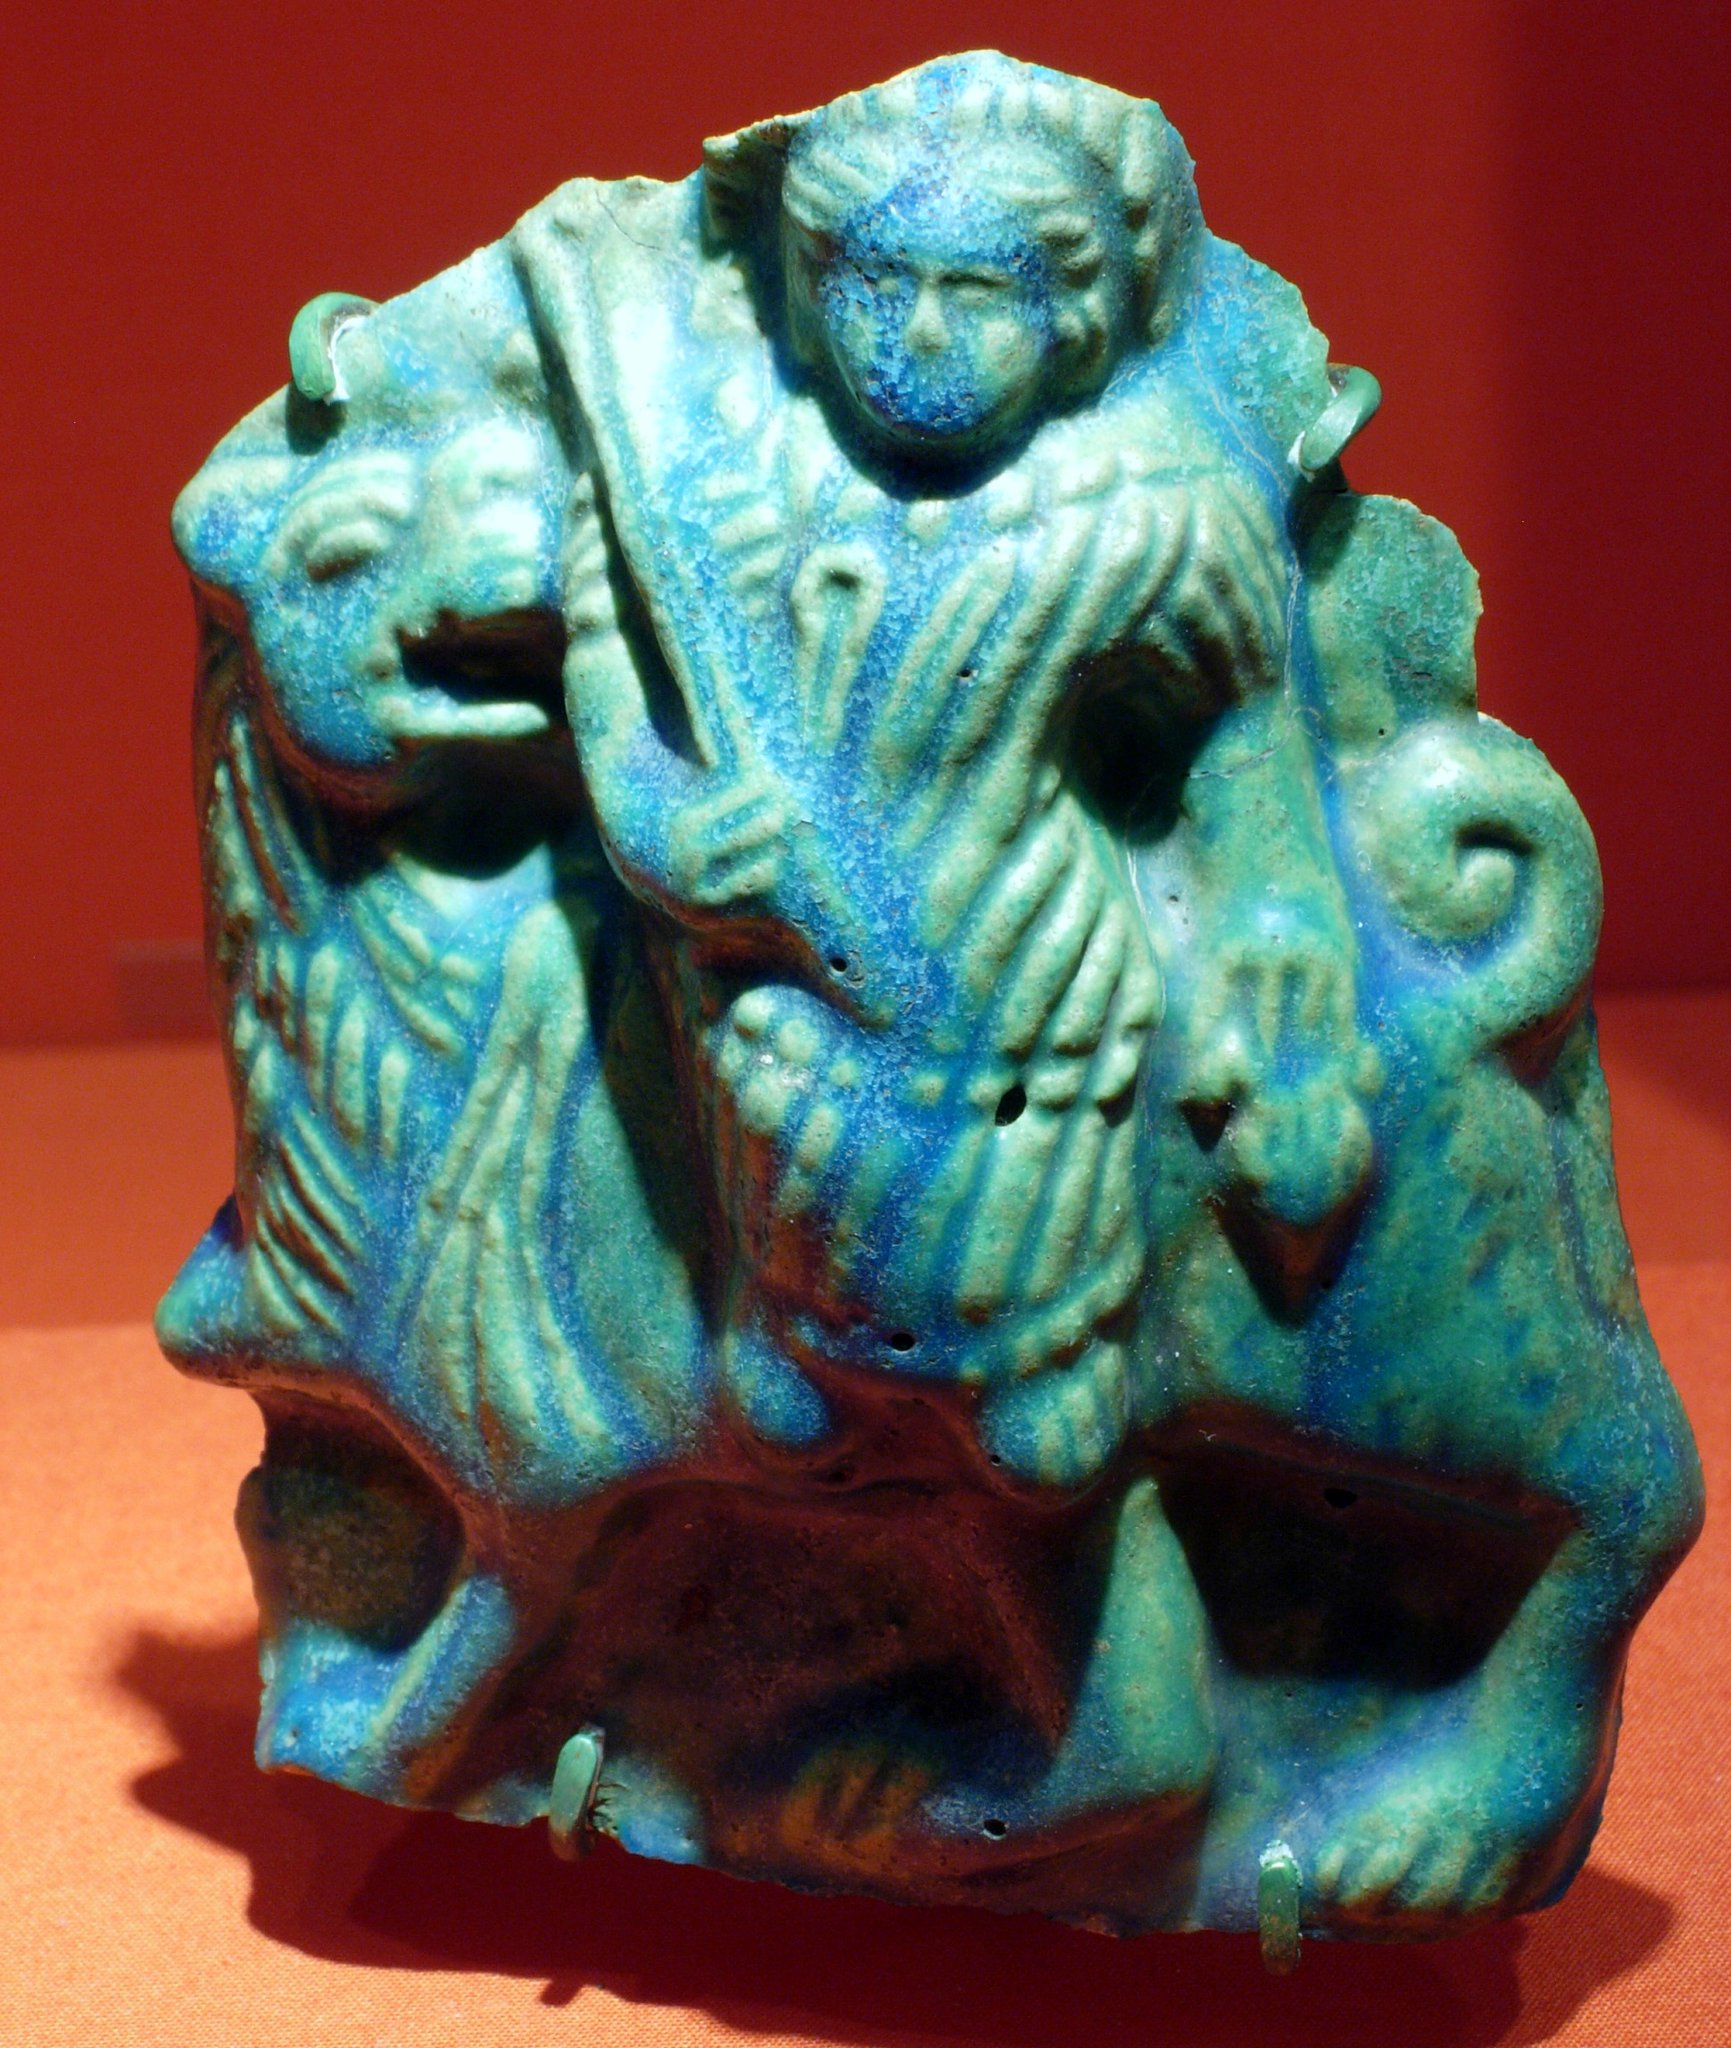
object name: plaque, god, lion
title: Plaque Depicting a God(?) Riding a Lion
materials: faience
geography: egypt